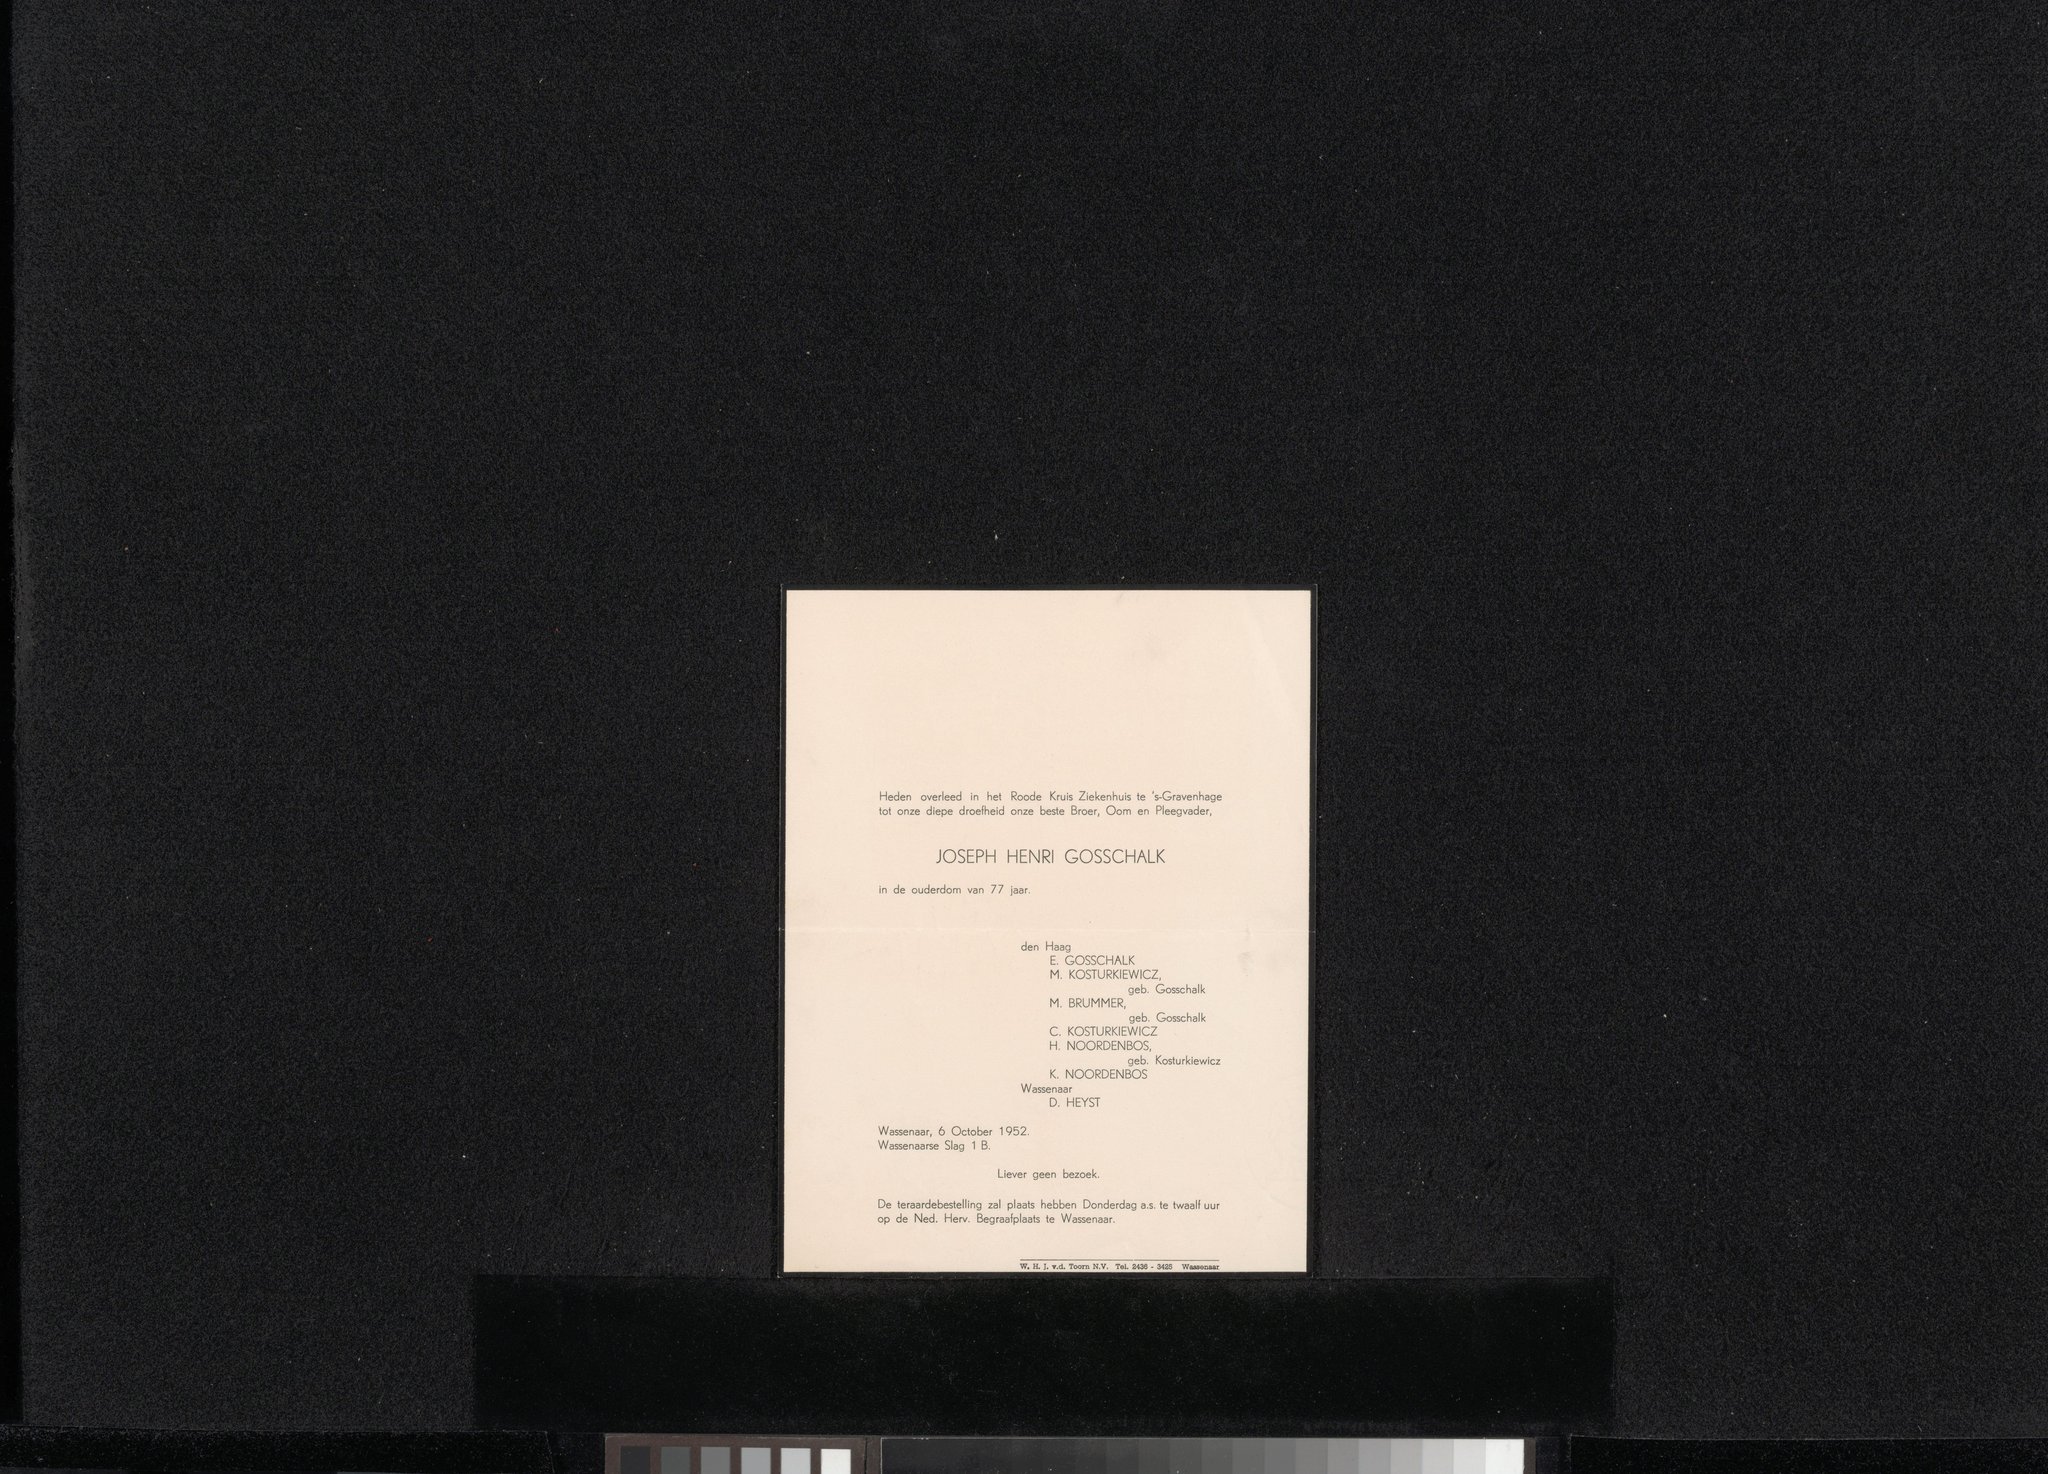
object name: overlijdensbericht, overlijdensadvertentie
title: Overlijdensbericht aan jonkheer Hendrik Teding van Berkhout (1879-1969)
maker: Anonymous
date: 1952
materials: paper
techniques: printing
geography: wassenaar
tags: print maker, joseph henry gosschalk, haarlem, amsterdam, jonkheer hendrik teding van berkhout (1879-1969)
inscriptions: watermark